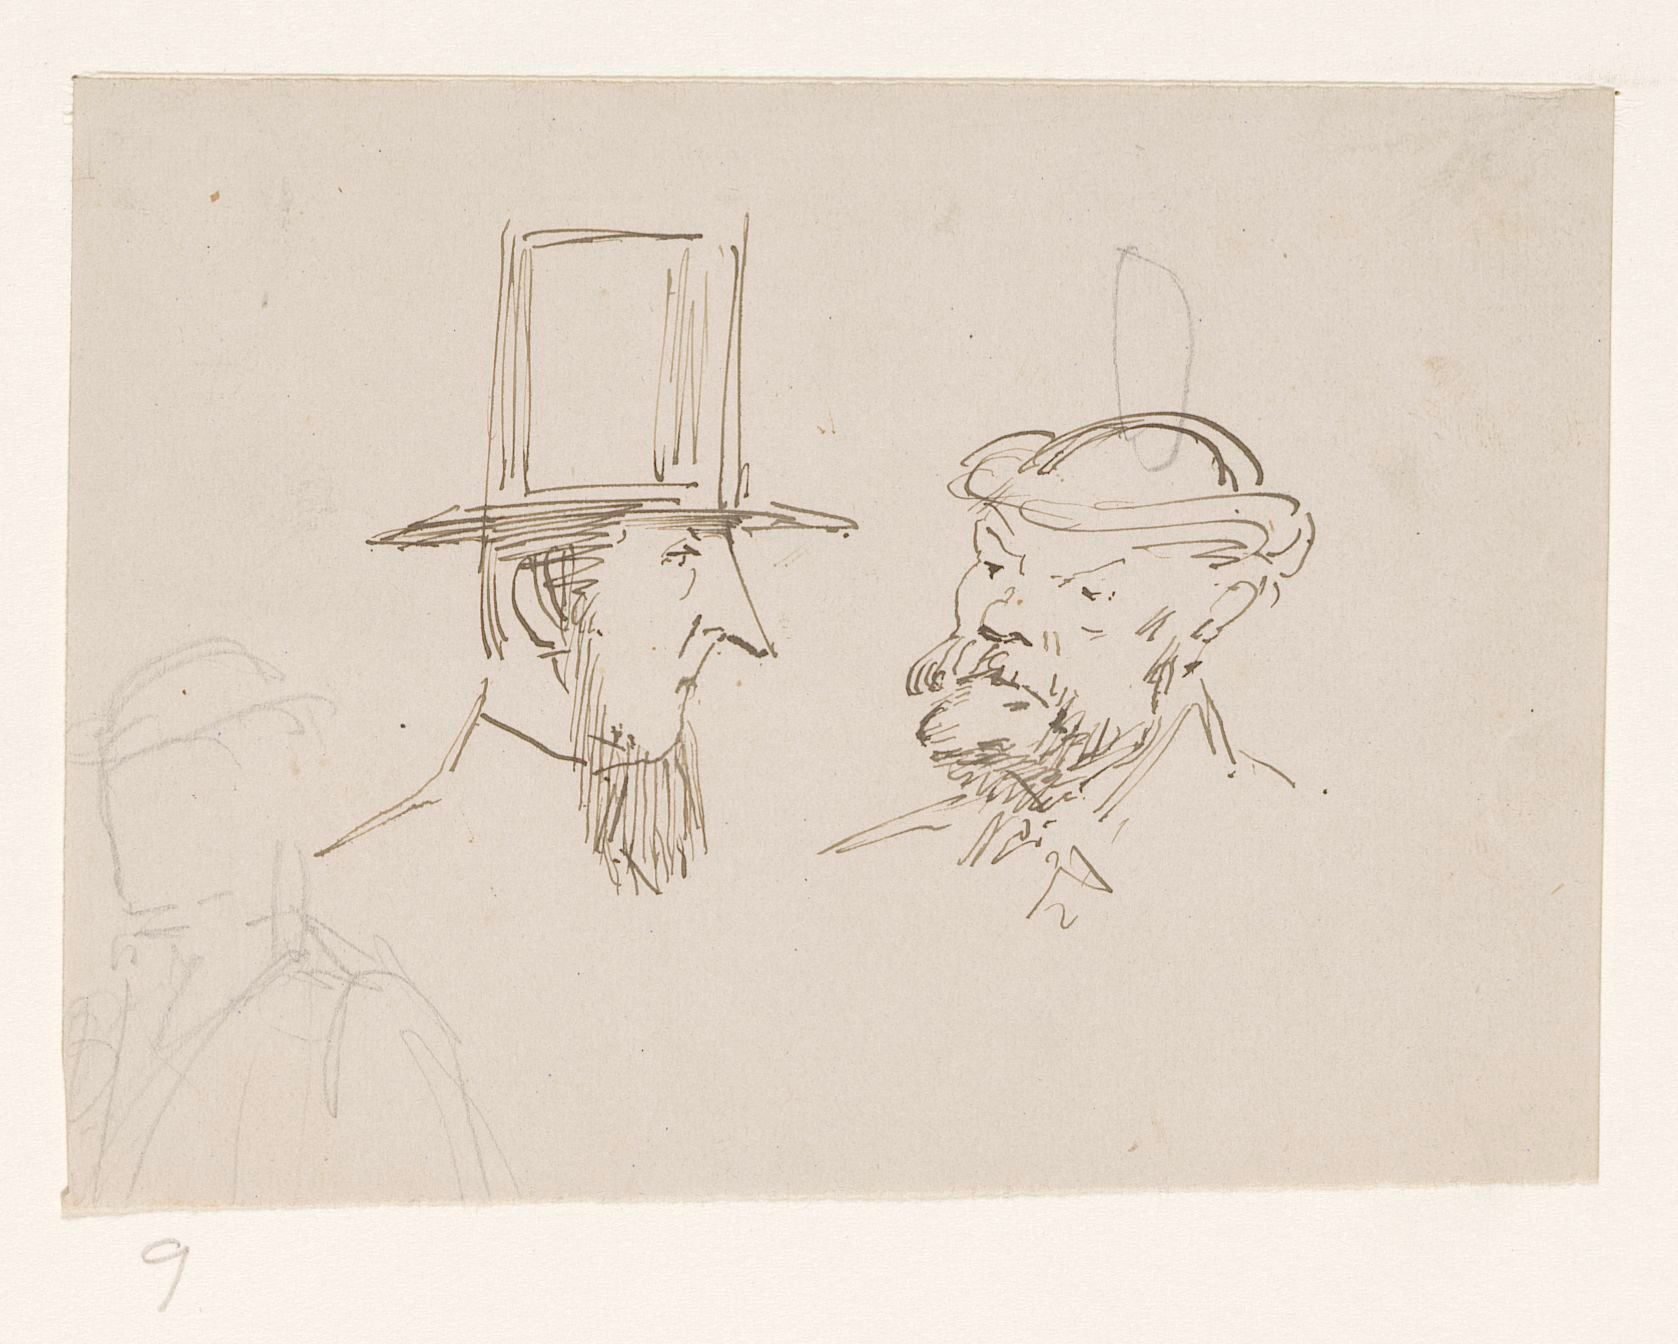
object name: cartoon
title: Portretschets van twee onbekenden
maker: johan michaël schmidt crans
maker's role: draughtsman, print maker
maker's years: 1830-1907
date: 1875-1895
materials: ink, paper, pencil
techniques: pen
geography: netherlands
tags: political caricatures and satires, historical persons not known by name, netherlands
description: Schetsblad met een van twee onbekende mannen, waarschijnlijk kamerleden. Voorstudie voor politieke spotprent.